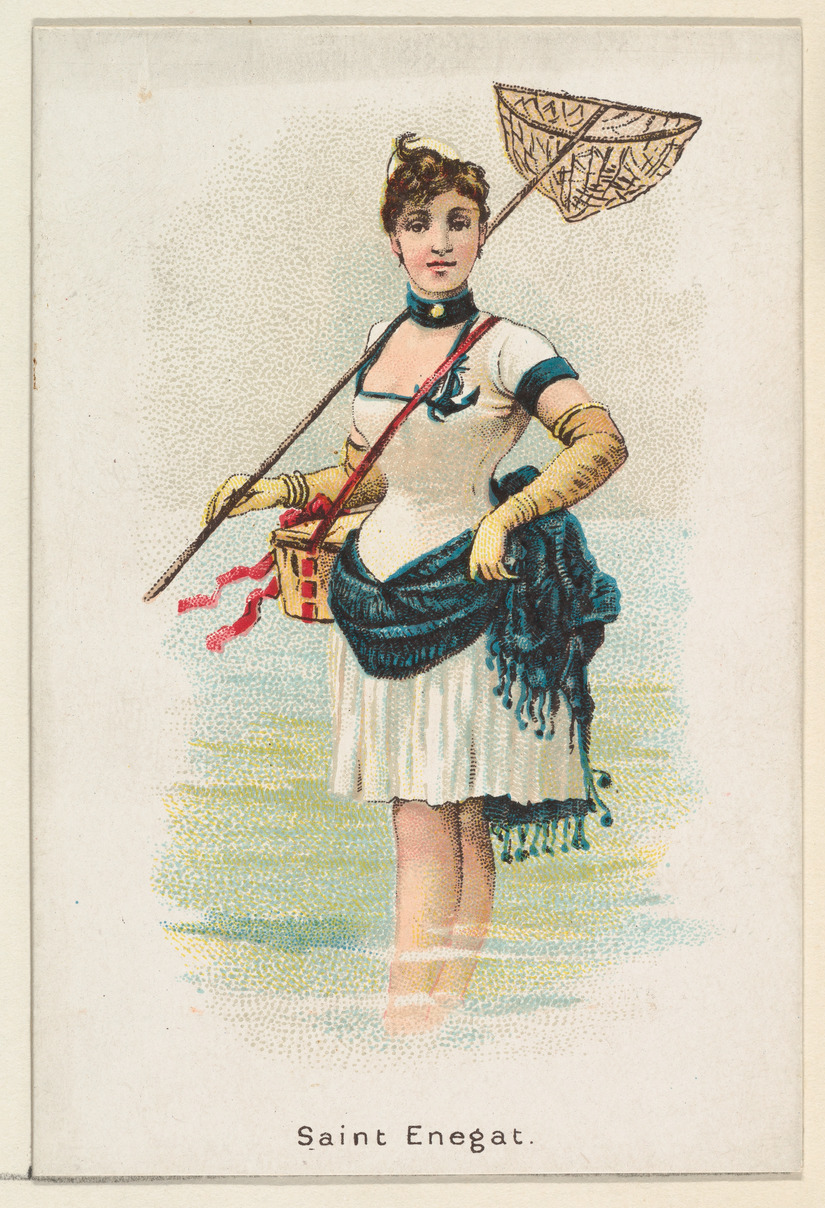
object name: print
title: Saint Enegat, from the Beautiful Bathers series (N192) issued by Wm. S. Kimball & Co.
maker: william s. kimball & company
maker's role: publisher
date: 1889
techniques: color lithograph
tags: women